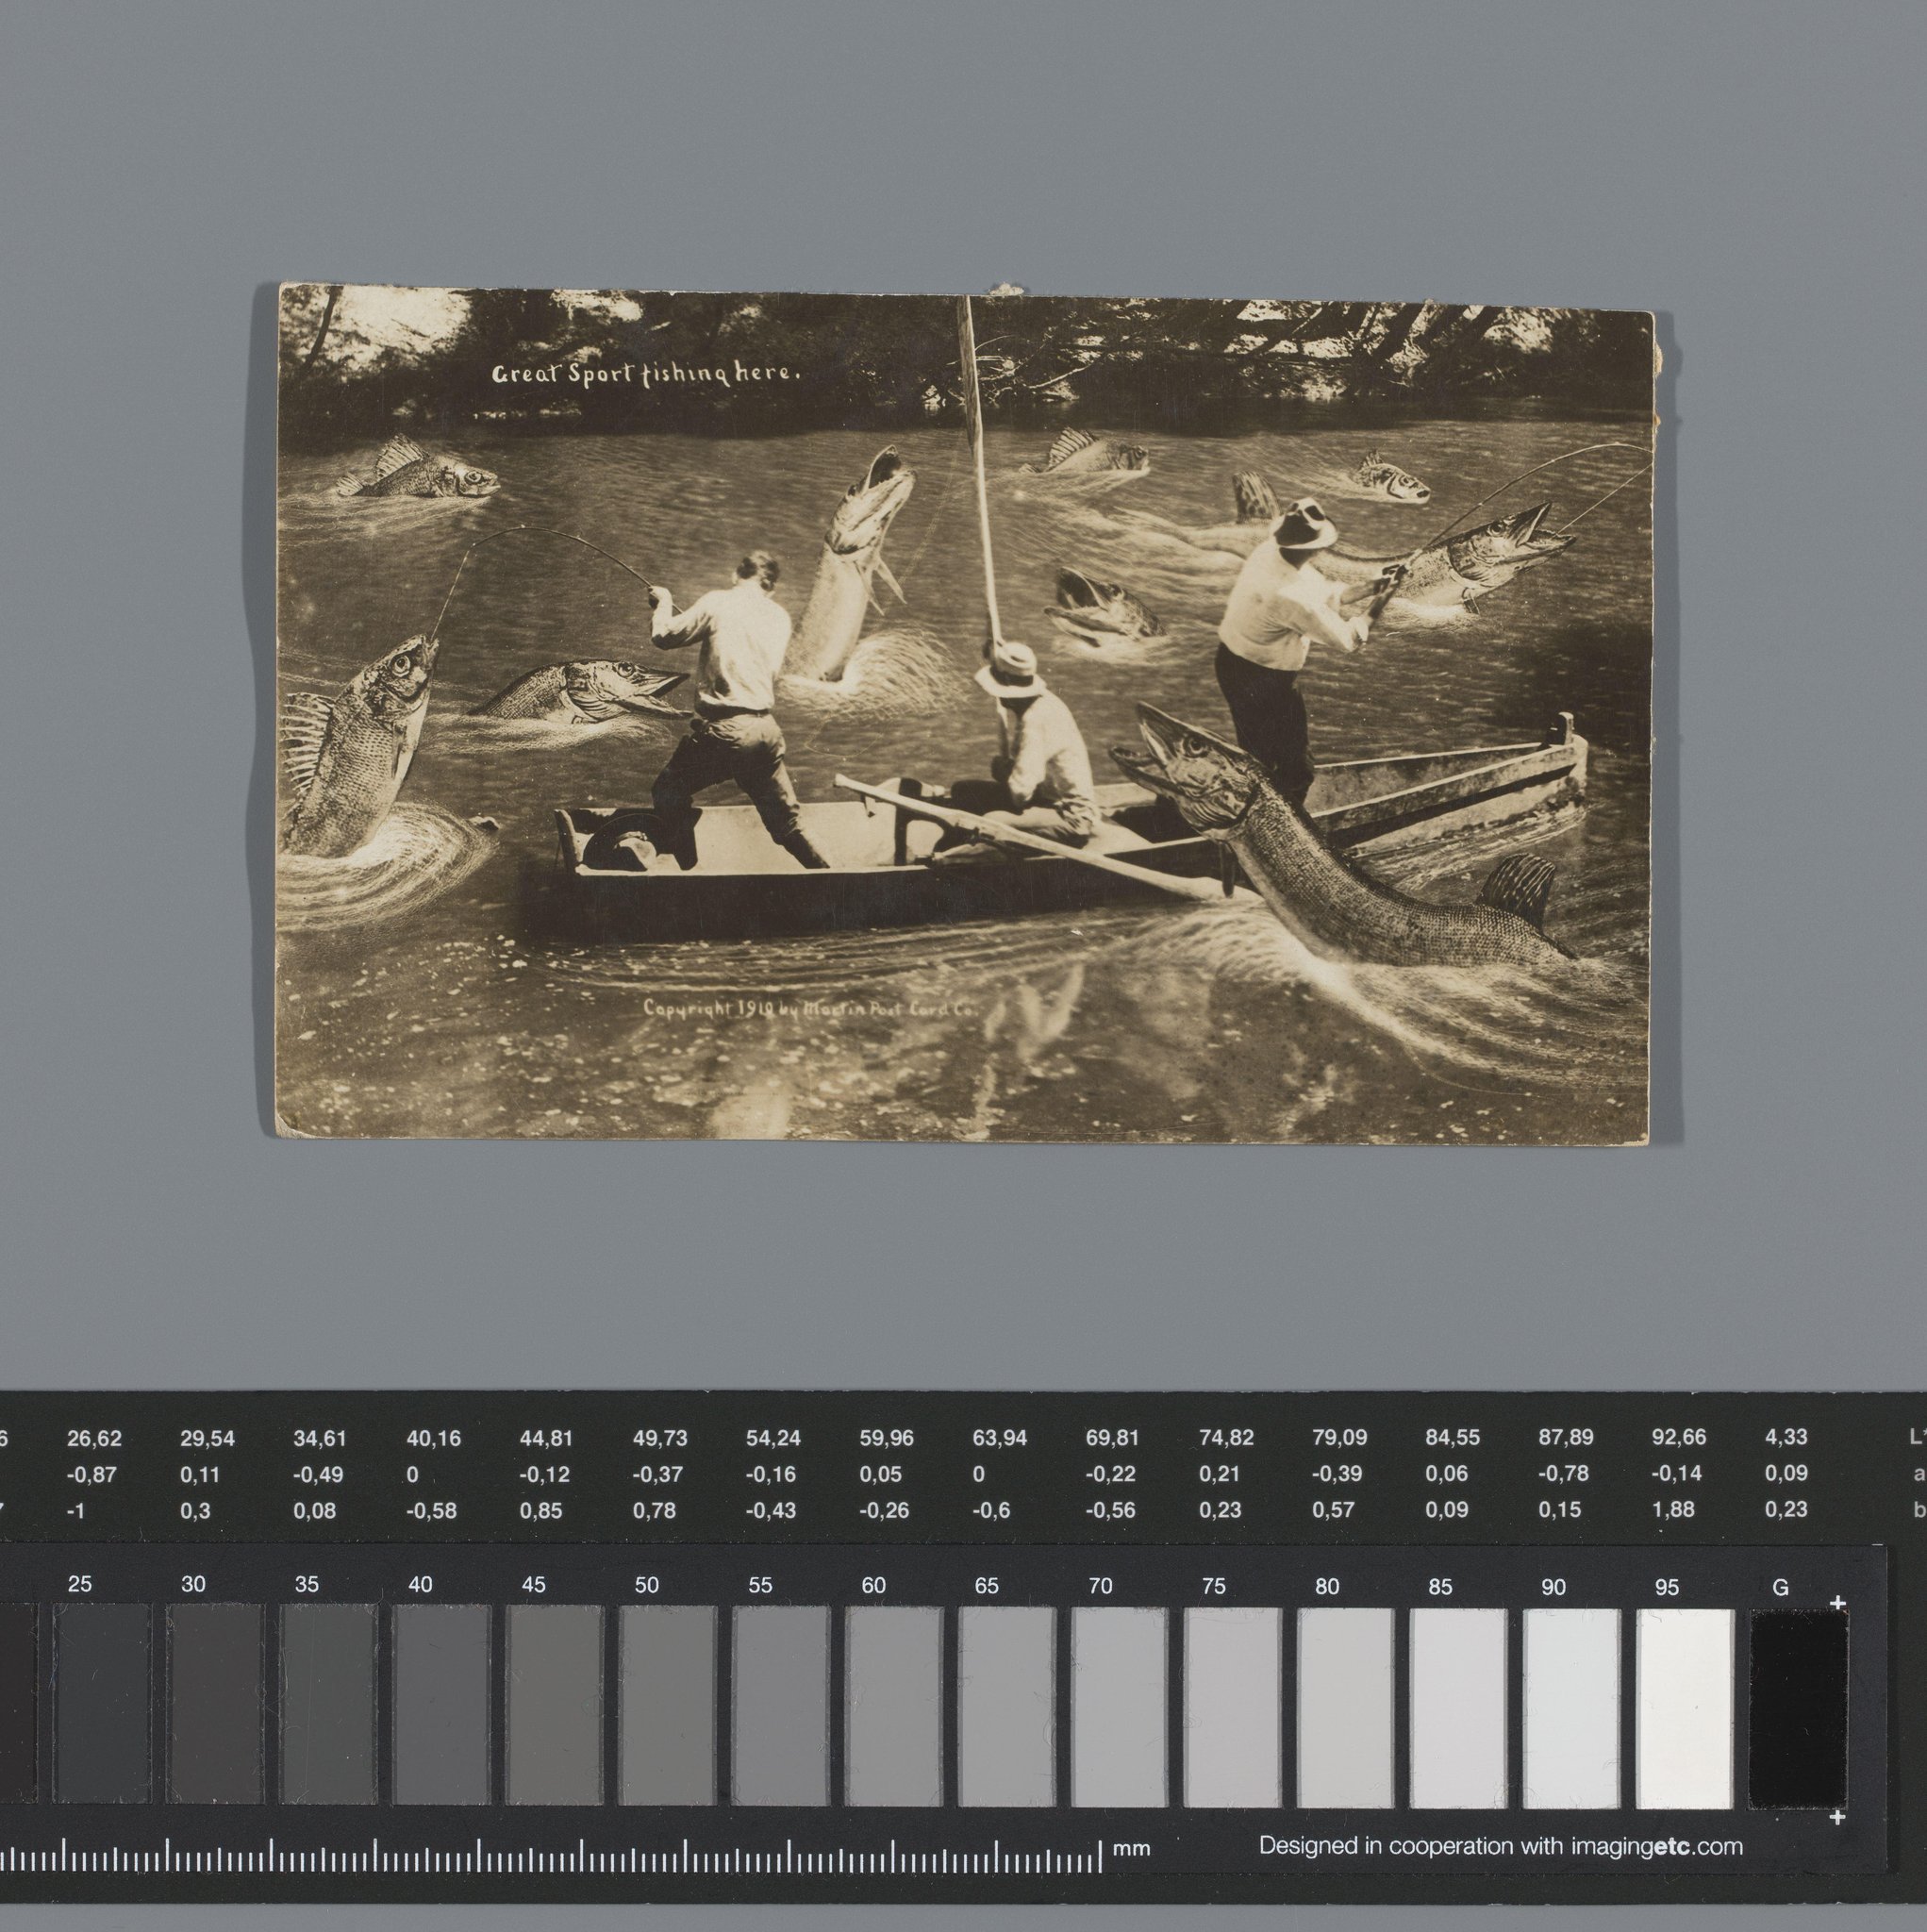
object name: ansichtkaart, prentbriefkaart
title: Fotomontage van 3 vissende mannen in een boot tussen reusachtige vissen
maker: william h. martin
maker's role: fotograaf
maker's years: 1865-1940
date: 1910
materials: photographic support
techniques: gelatin silver print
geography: united states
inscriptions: inscription: ‘Great Sport fishing here. / Copyright 1910 by Martin Post Card Co.’, inscription: ‘MARTIN / MARTIN / MARTIN / MARTIN / Pub. by / Martin / Ottawa / Kansas’, inscription: ‘FROM THE COLLECTION / OF / FRANK C. PERREAULT’